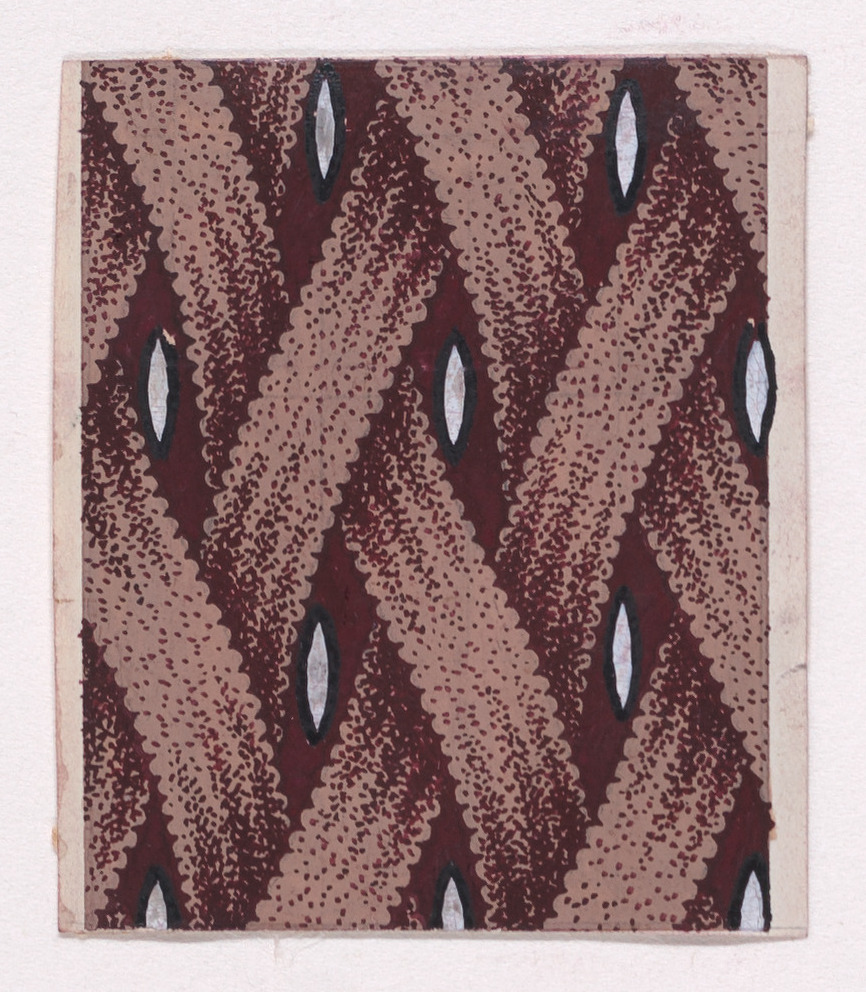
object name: drawing ornament architecture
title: Textile Design with a Basketweave Pattern and Alternating Rows of Lens-Shaped Pearls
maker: anonymous, alsatian, 19th century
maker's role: artist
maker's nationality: alsatian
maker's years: 1800-1900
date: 1840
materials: gouache